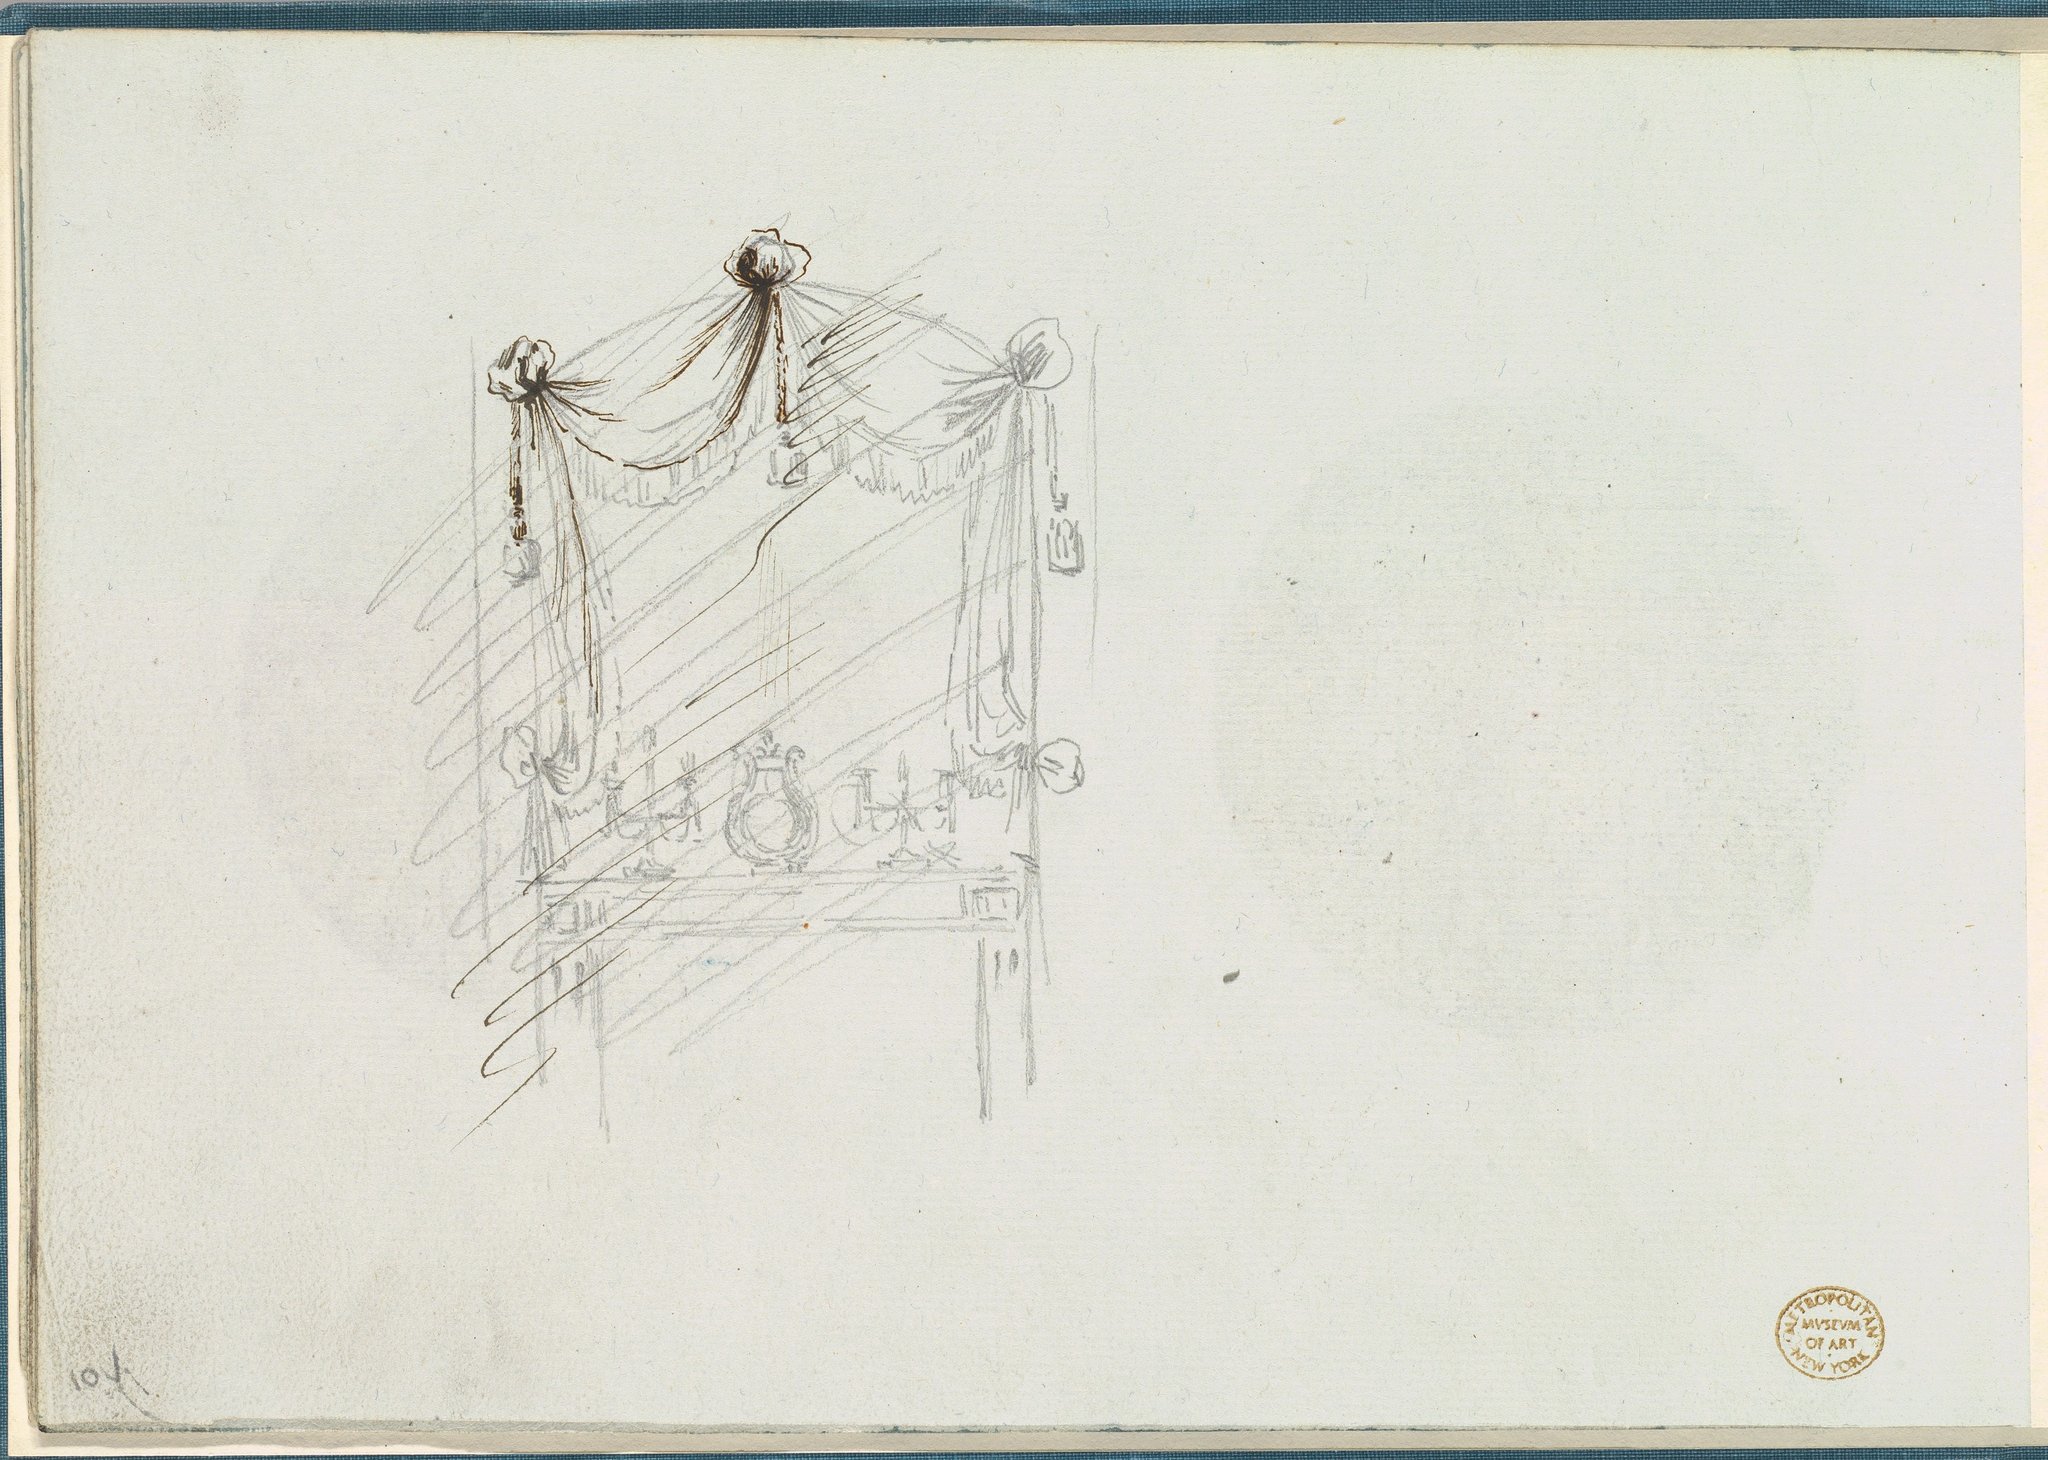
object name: collection ornament architecture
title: Sketch of a Fireplace with a Mirror Surrounded by Drapery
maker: anonymous, french, 18th century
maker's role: artist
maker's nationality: french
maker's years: 1700-1800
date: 1785-1790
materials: graphite, ink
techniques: pen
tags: fireplaces,mirrors